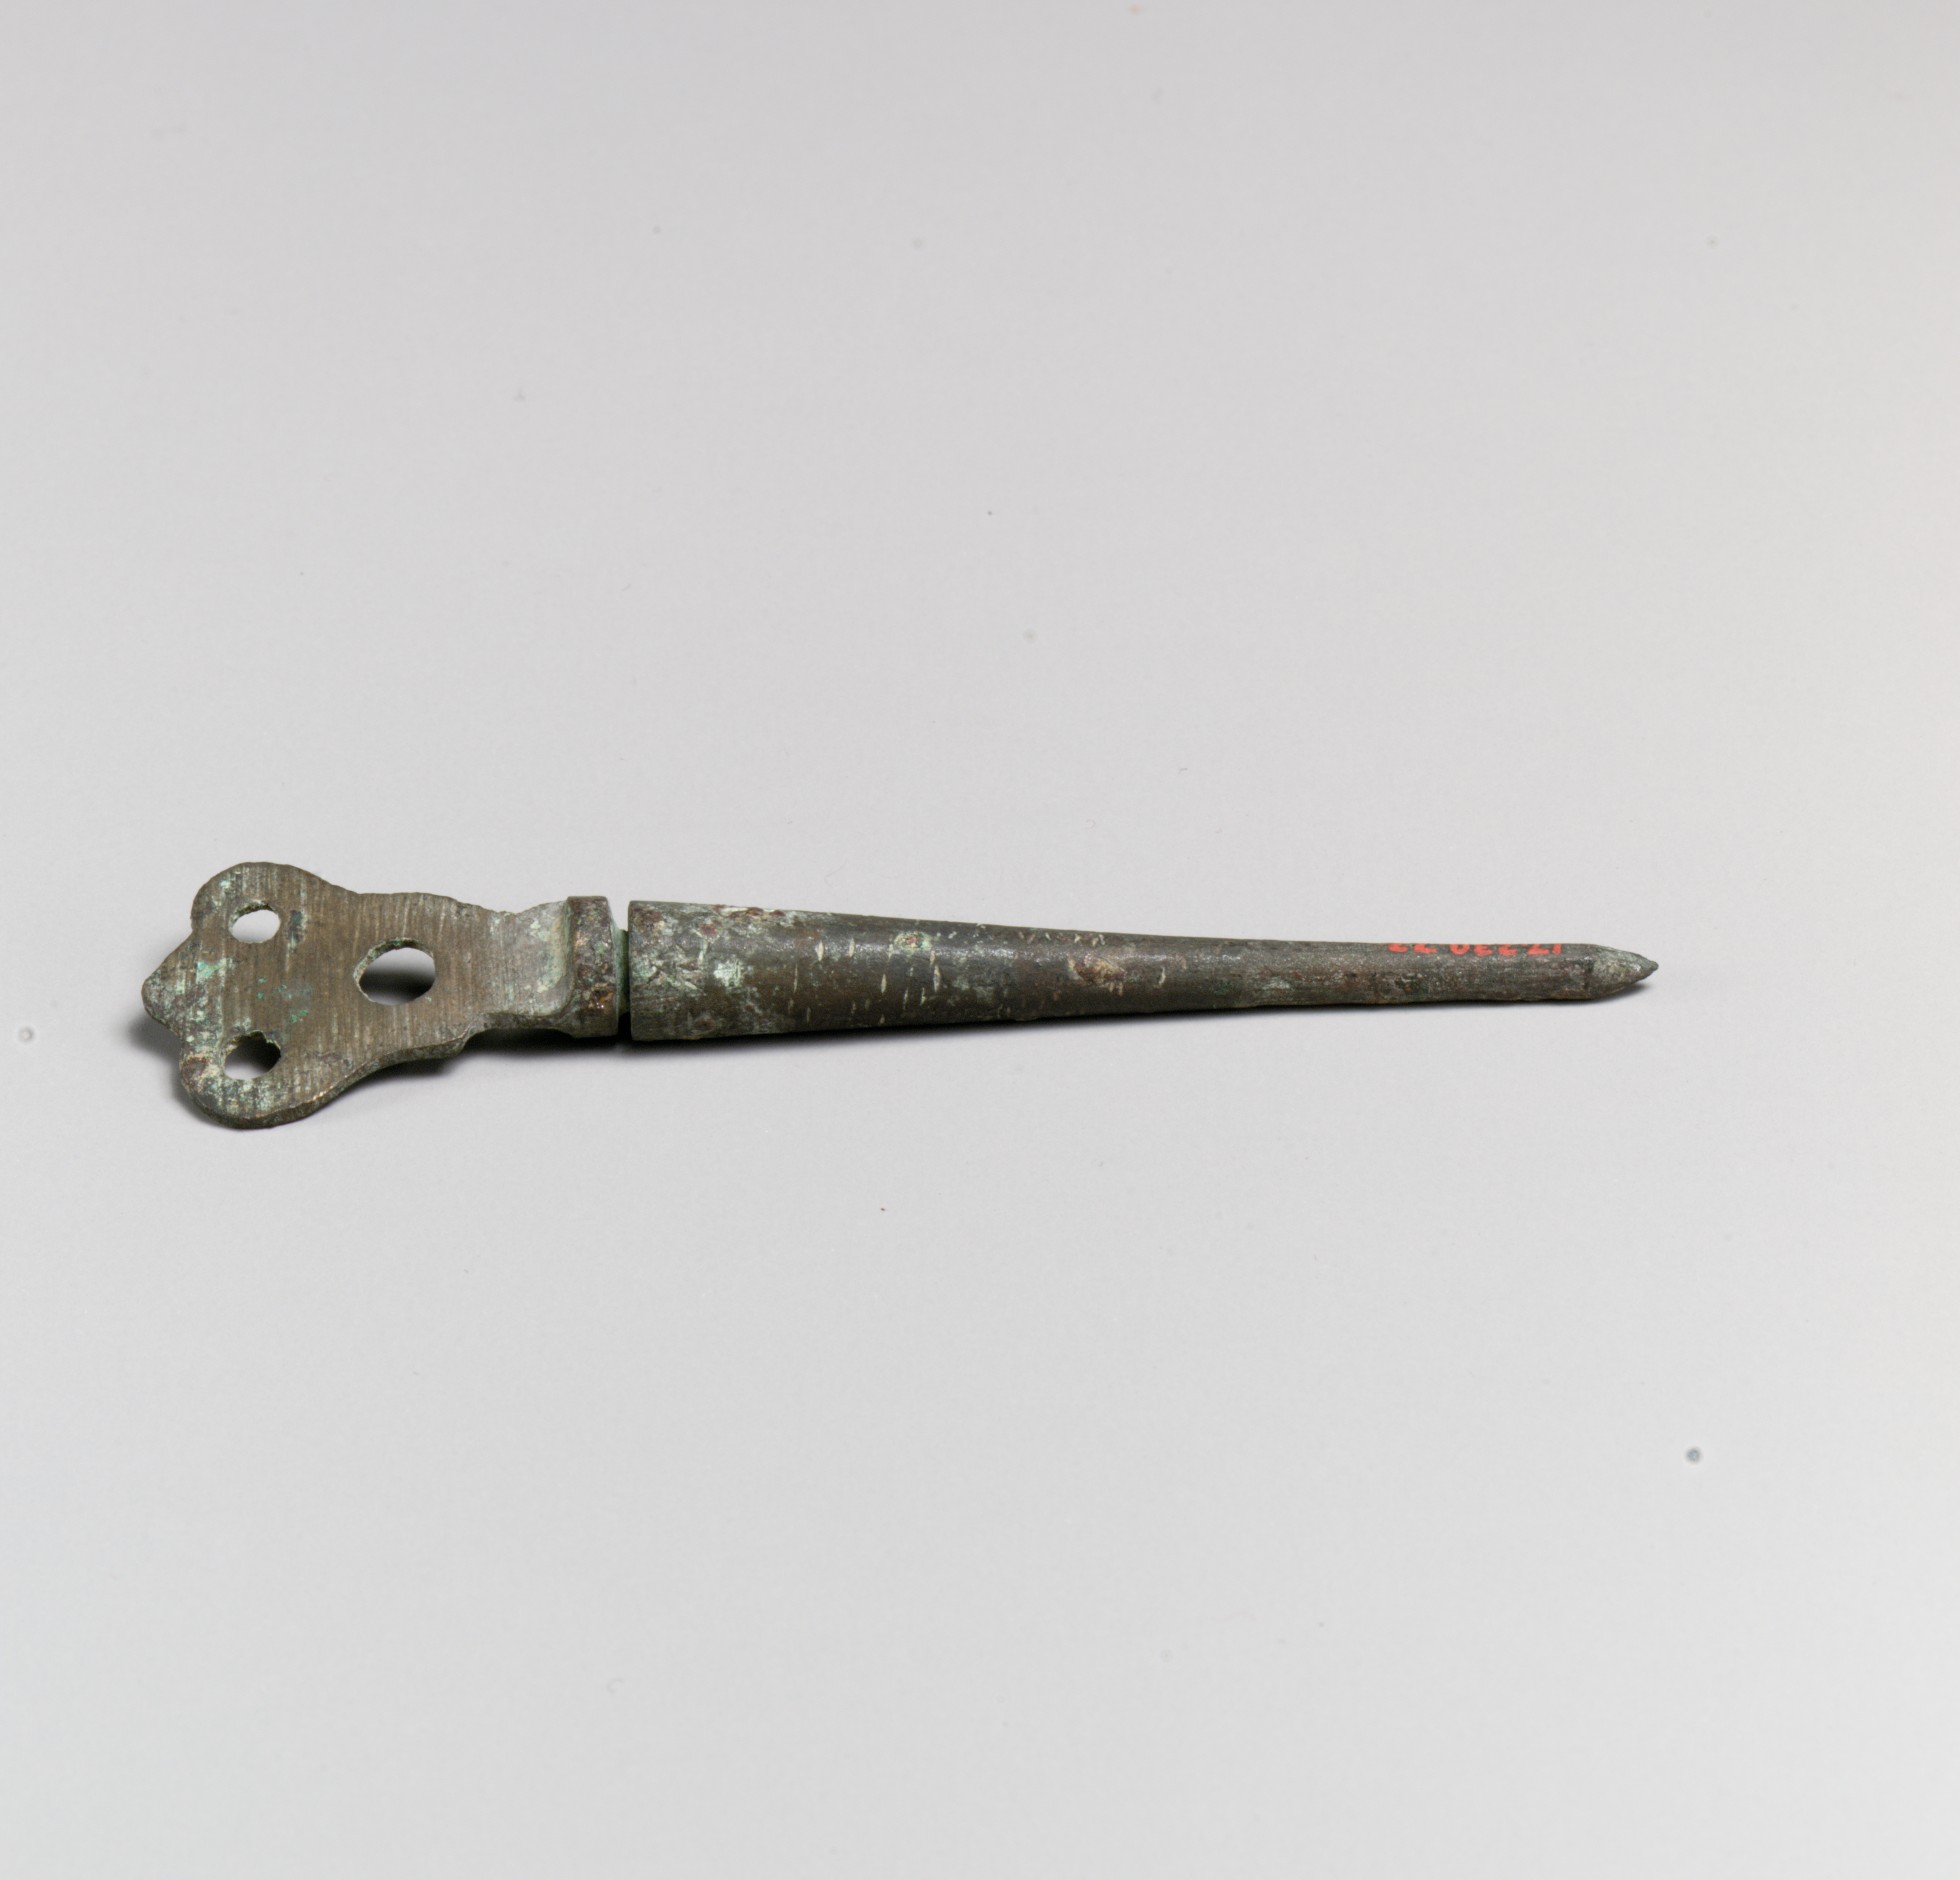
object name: implement, cone shaped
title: Implement, cone-shaped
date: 7000 BCE-330 CE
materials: bronze